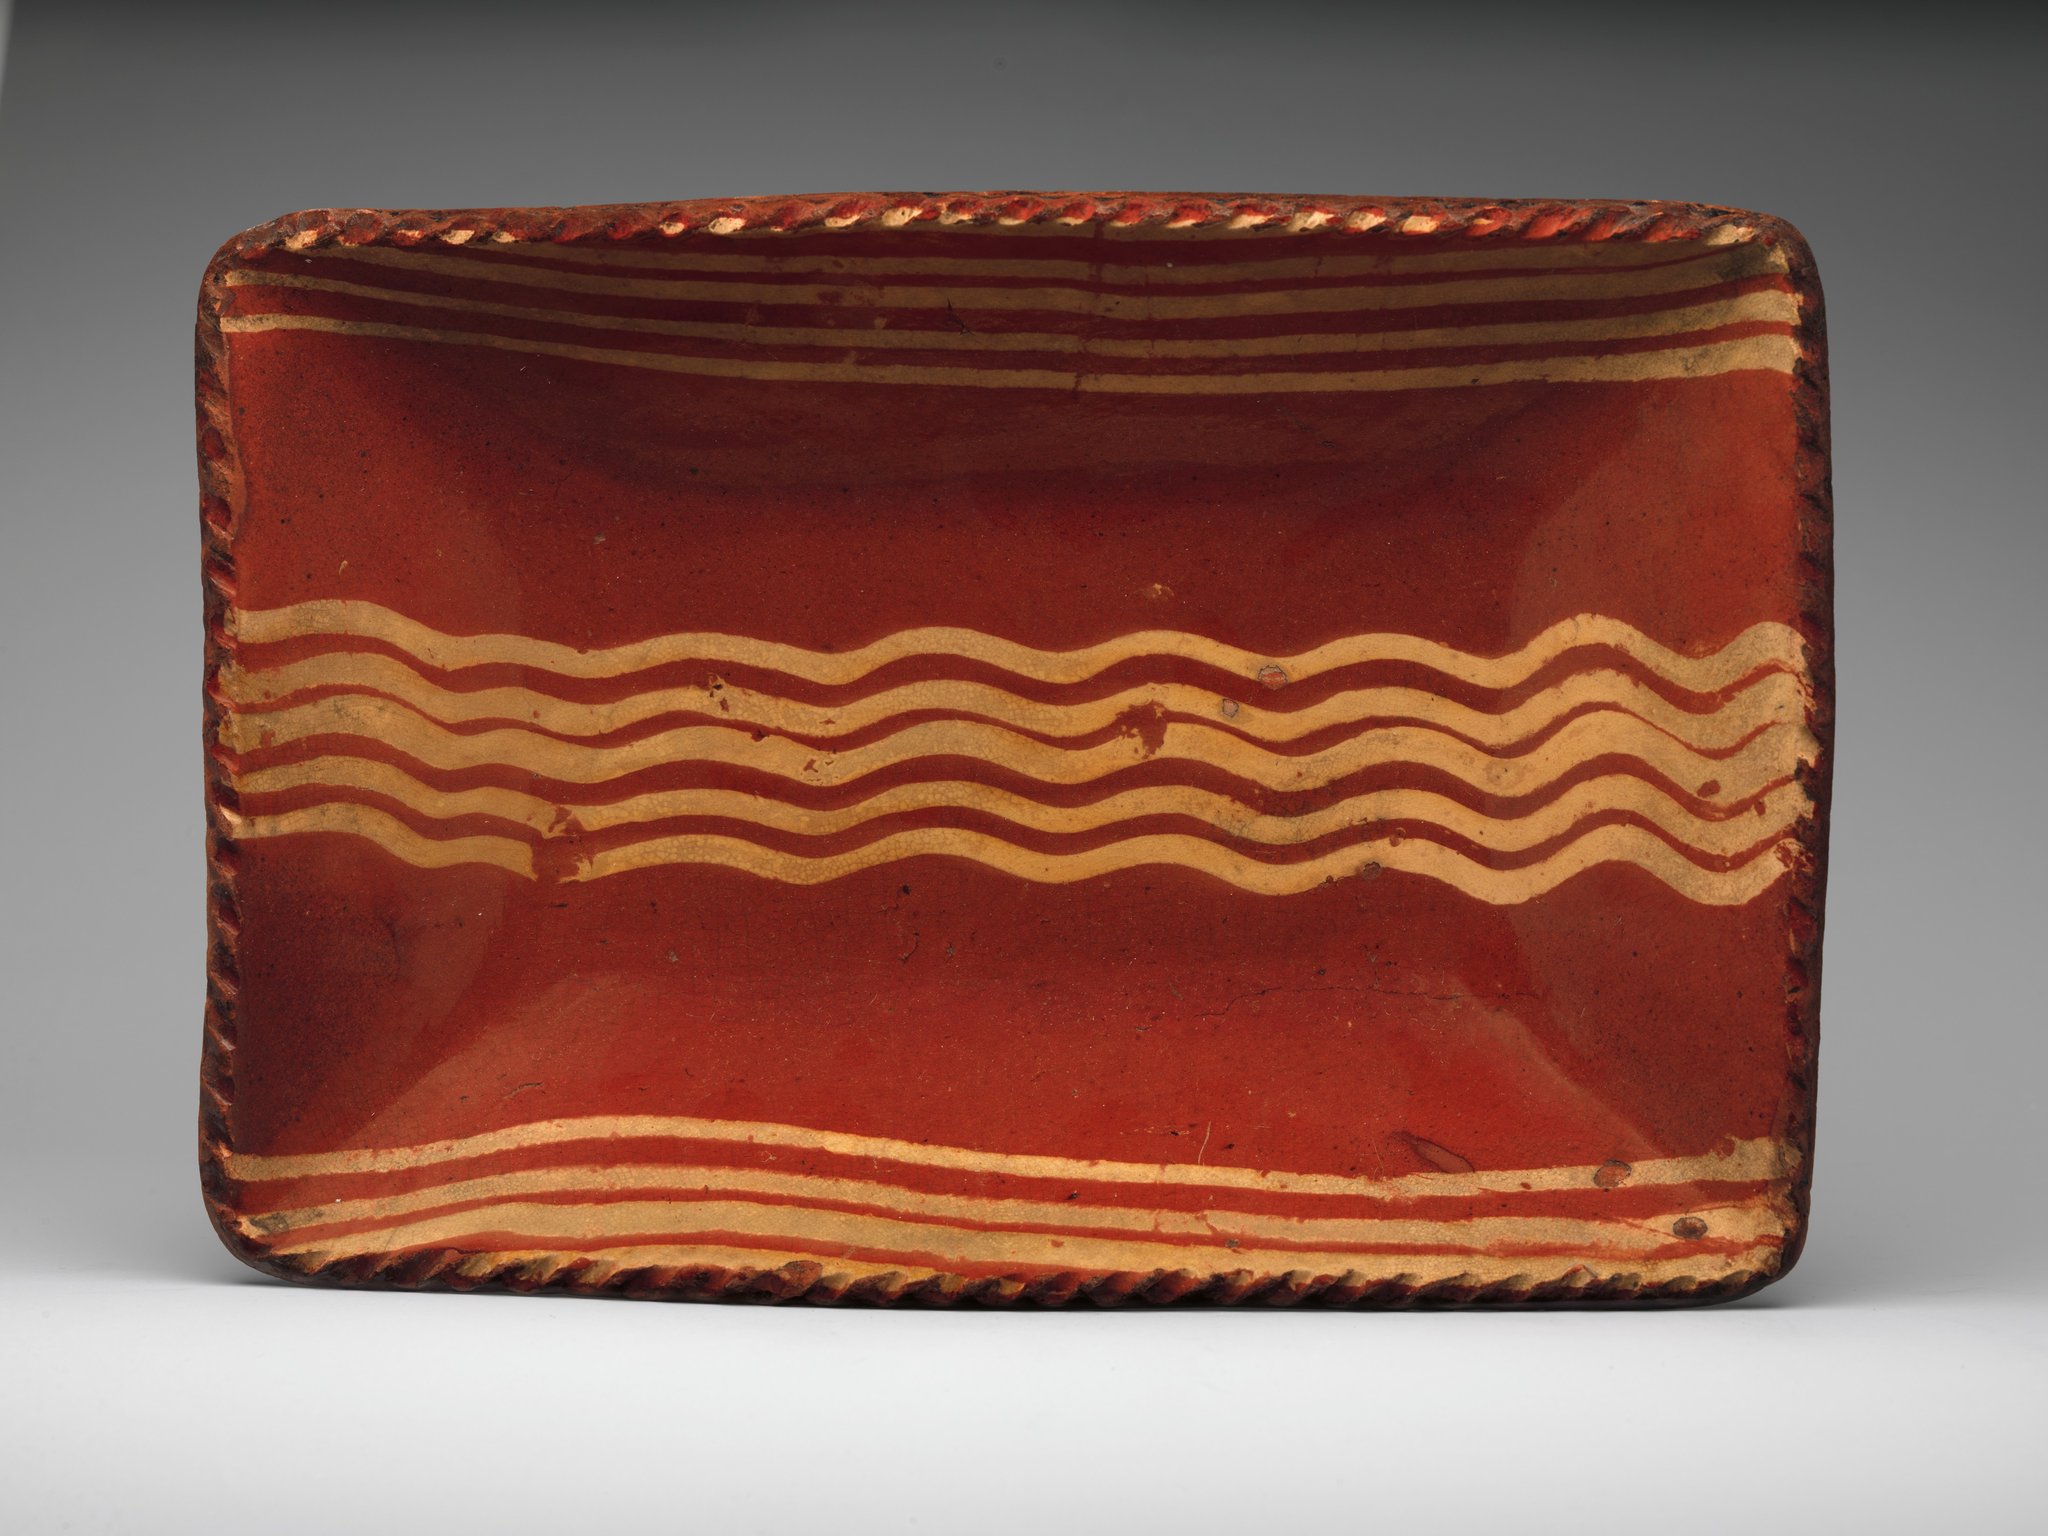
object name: dish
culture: american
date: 1780-1790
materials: earthenware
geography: united states